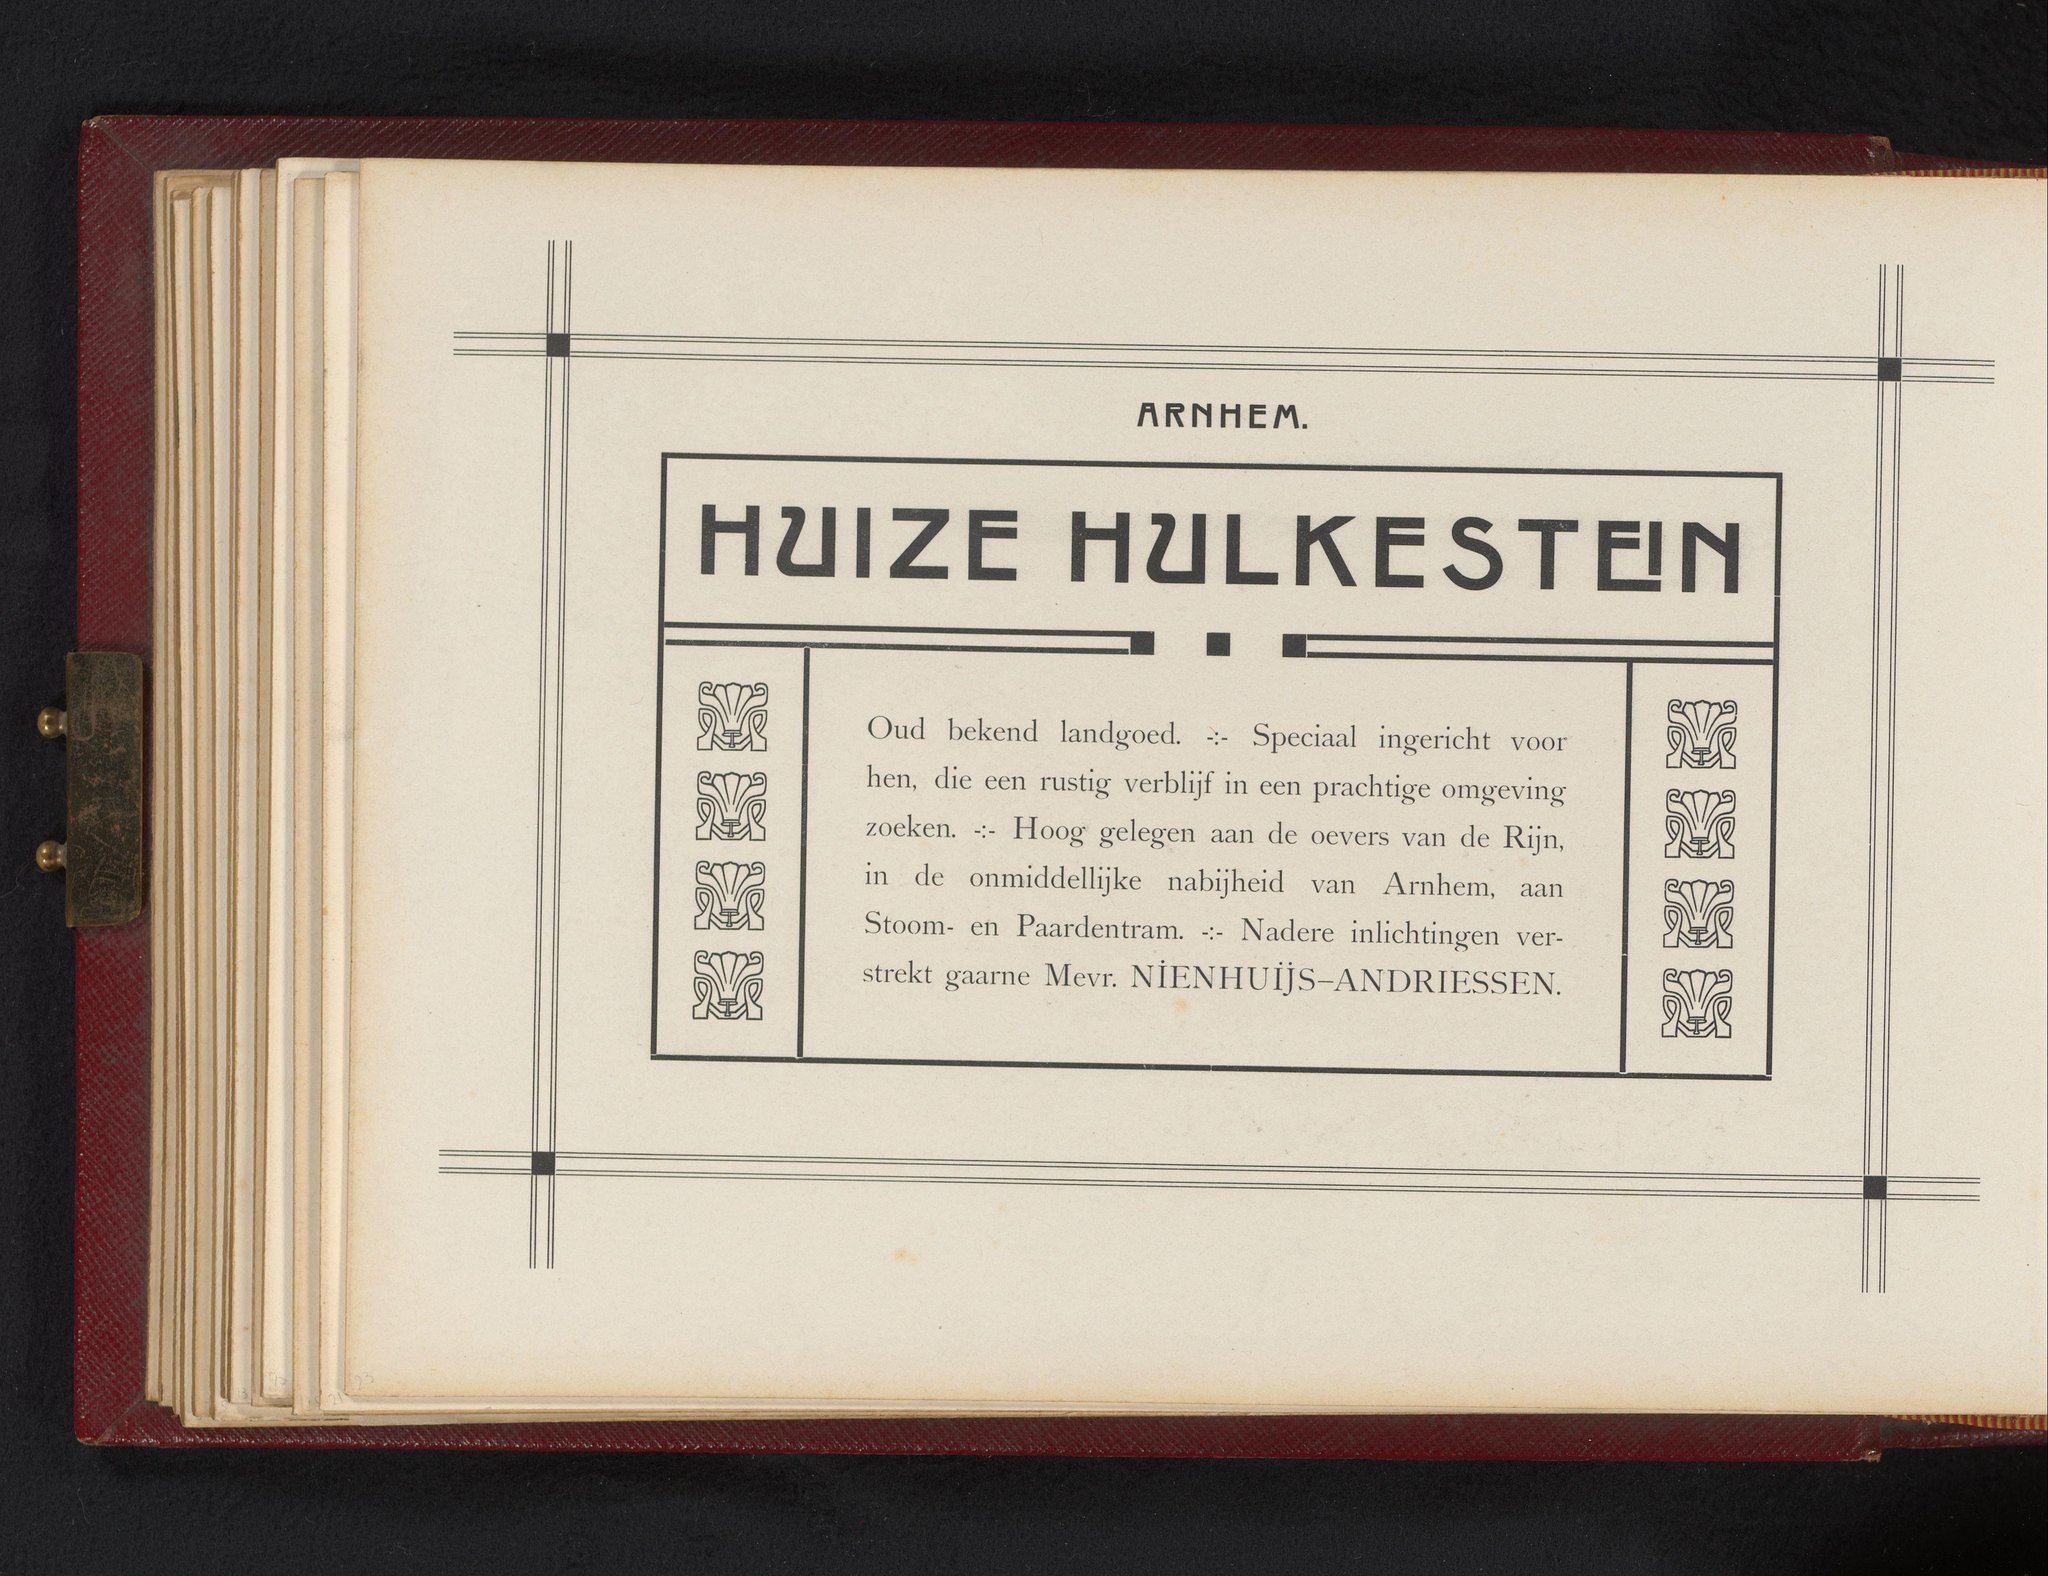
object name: album leaf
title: Advertentie voor Huize Hulkestein bij Arnhem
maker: Anonymous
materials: paper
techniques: printing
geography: netherlands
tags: advertising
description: Deze pagina maakt deel uit van een album.